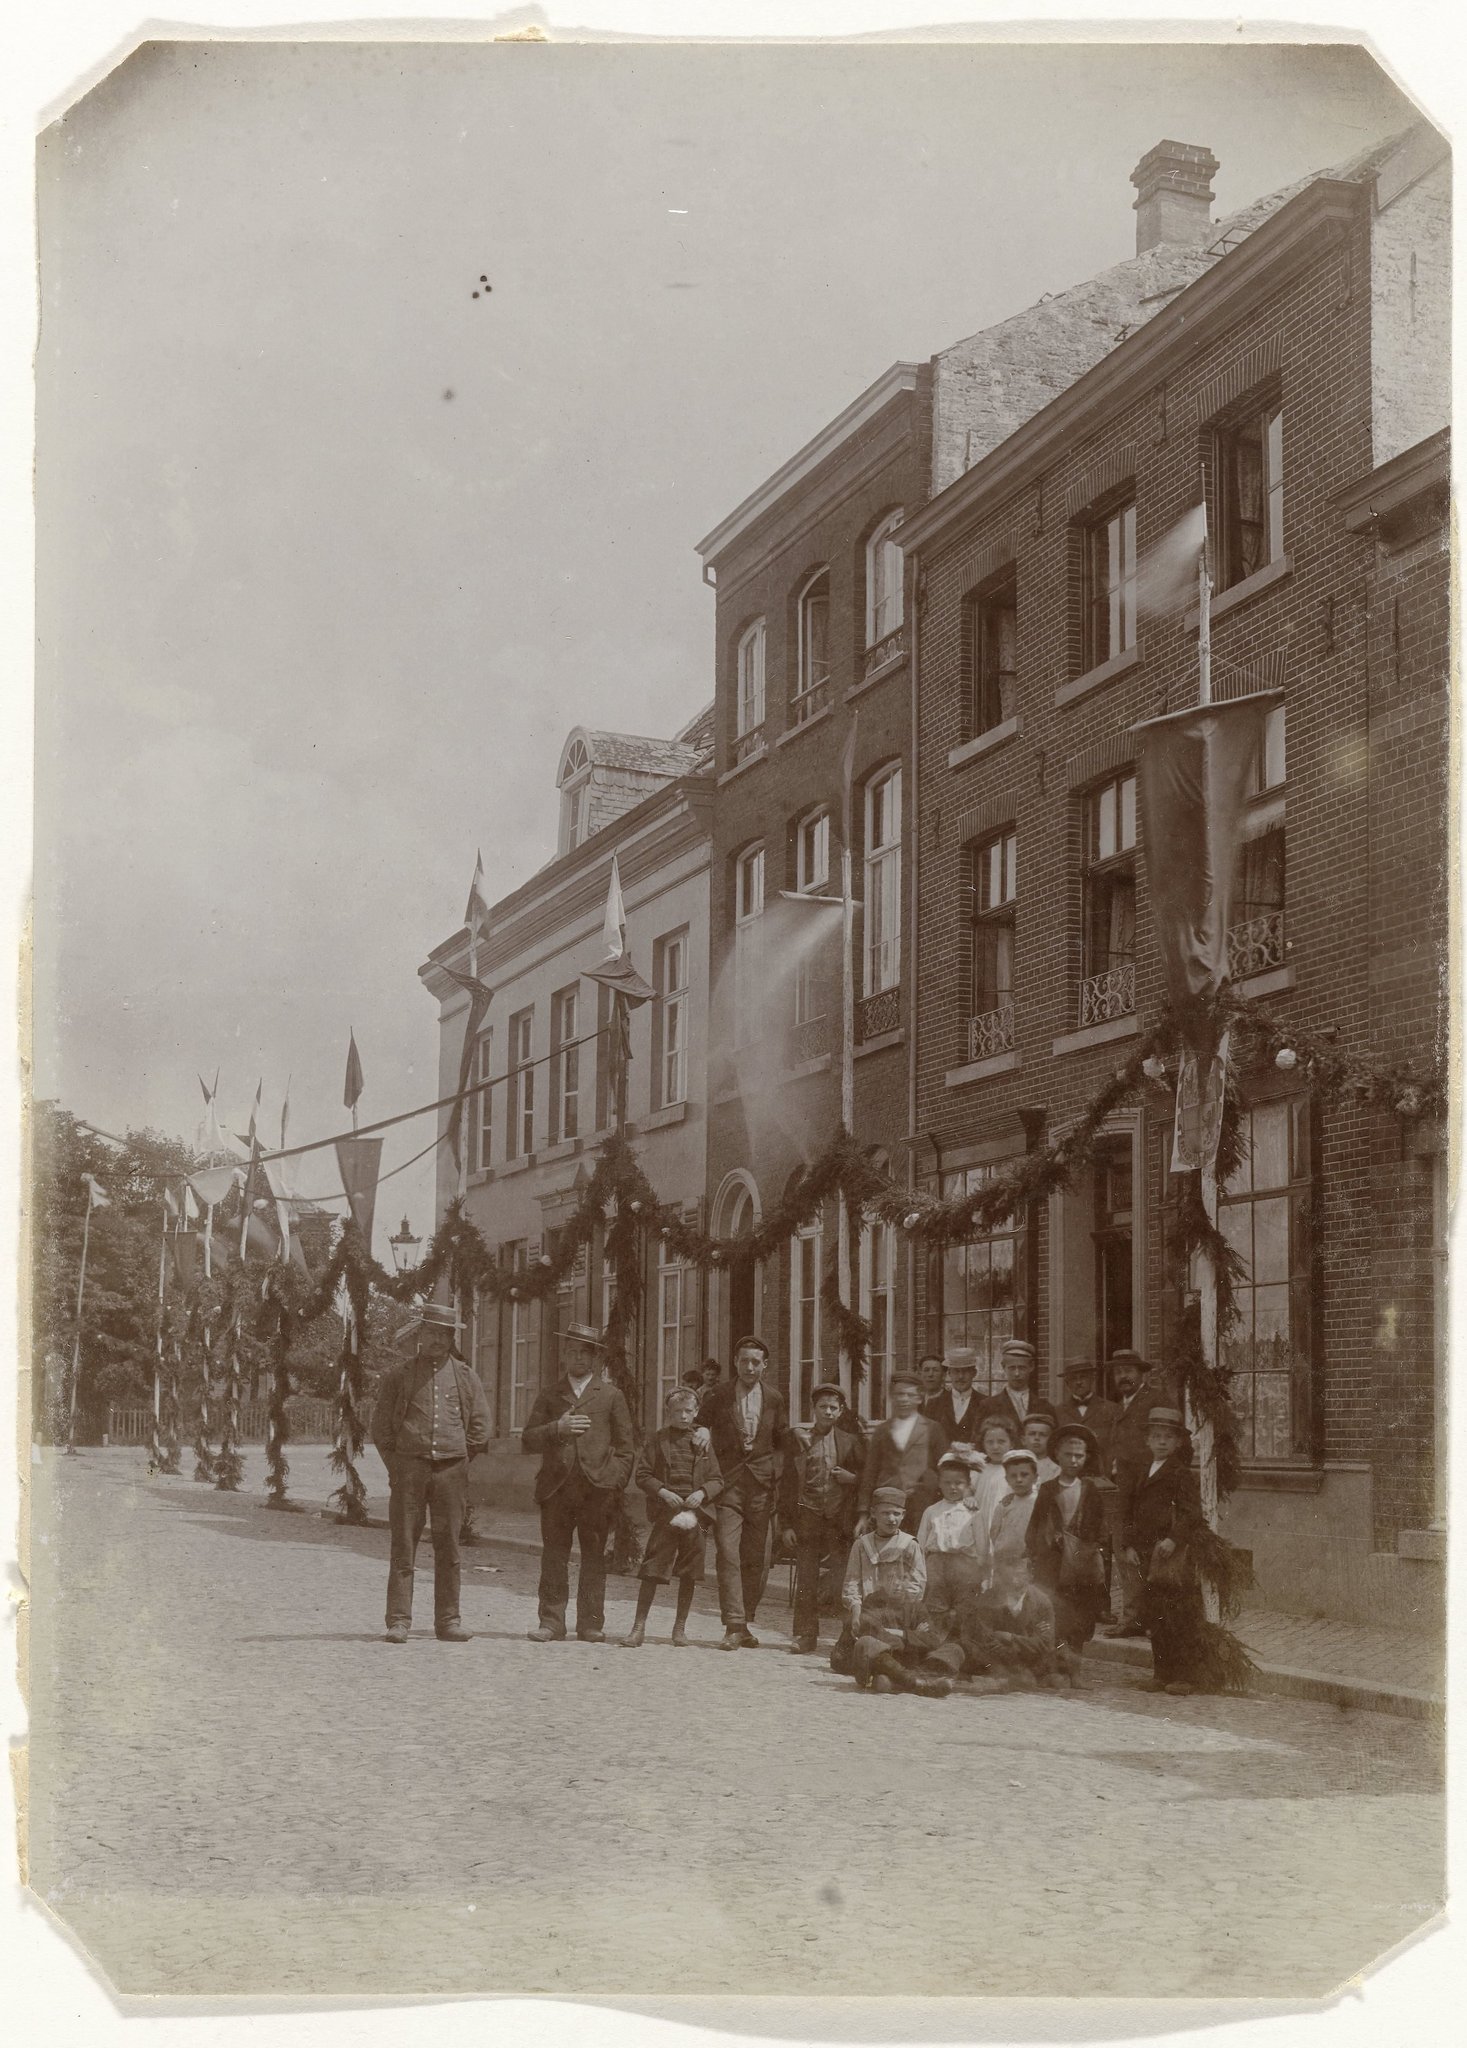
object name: photograph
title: Versierde straat ter gelegeheid van de inhulding of een bezoek van koningin Wilhelmina en prins Hendrik, op de voorgrond poseren mannen en kinderen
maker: Anonymous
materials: paper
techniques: collodion silver print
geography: netherlands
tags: public festivities, netherlands